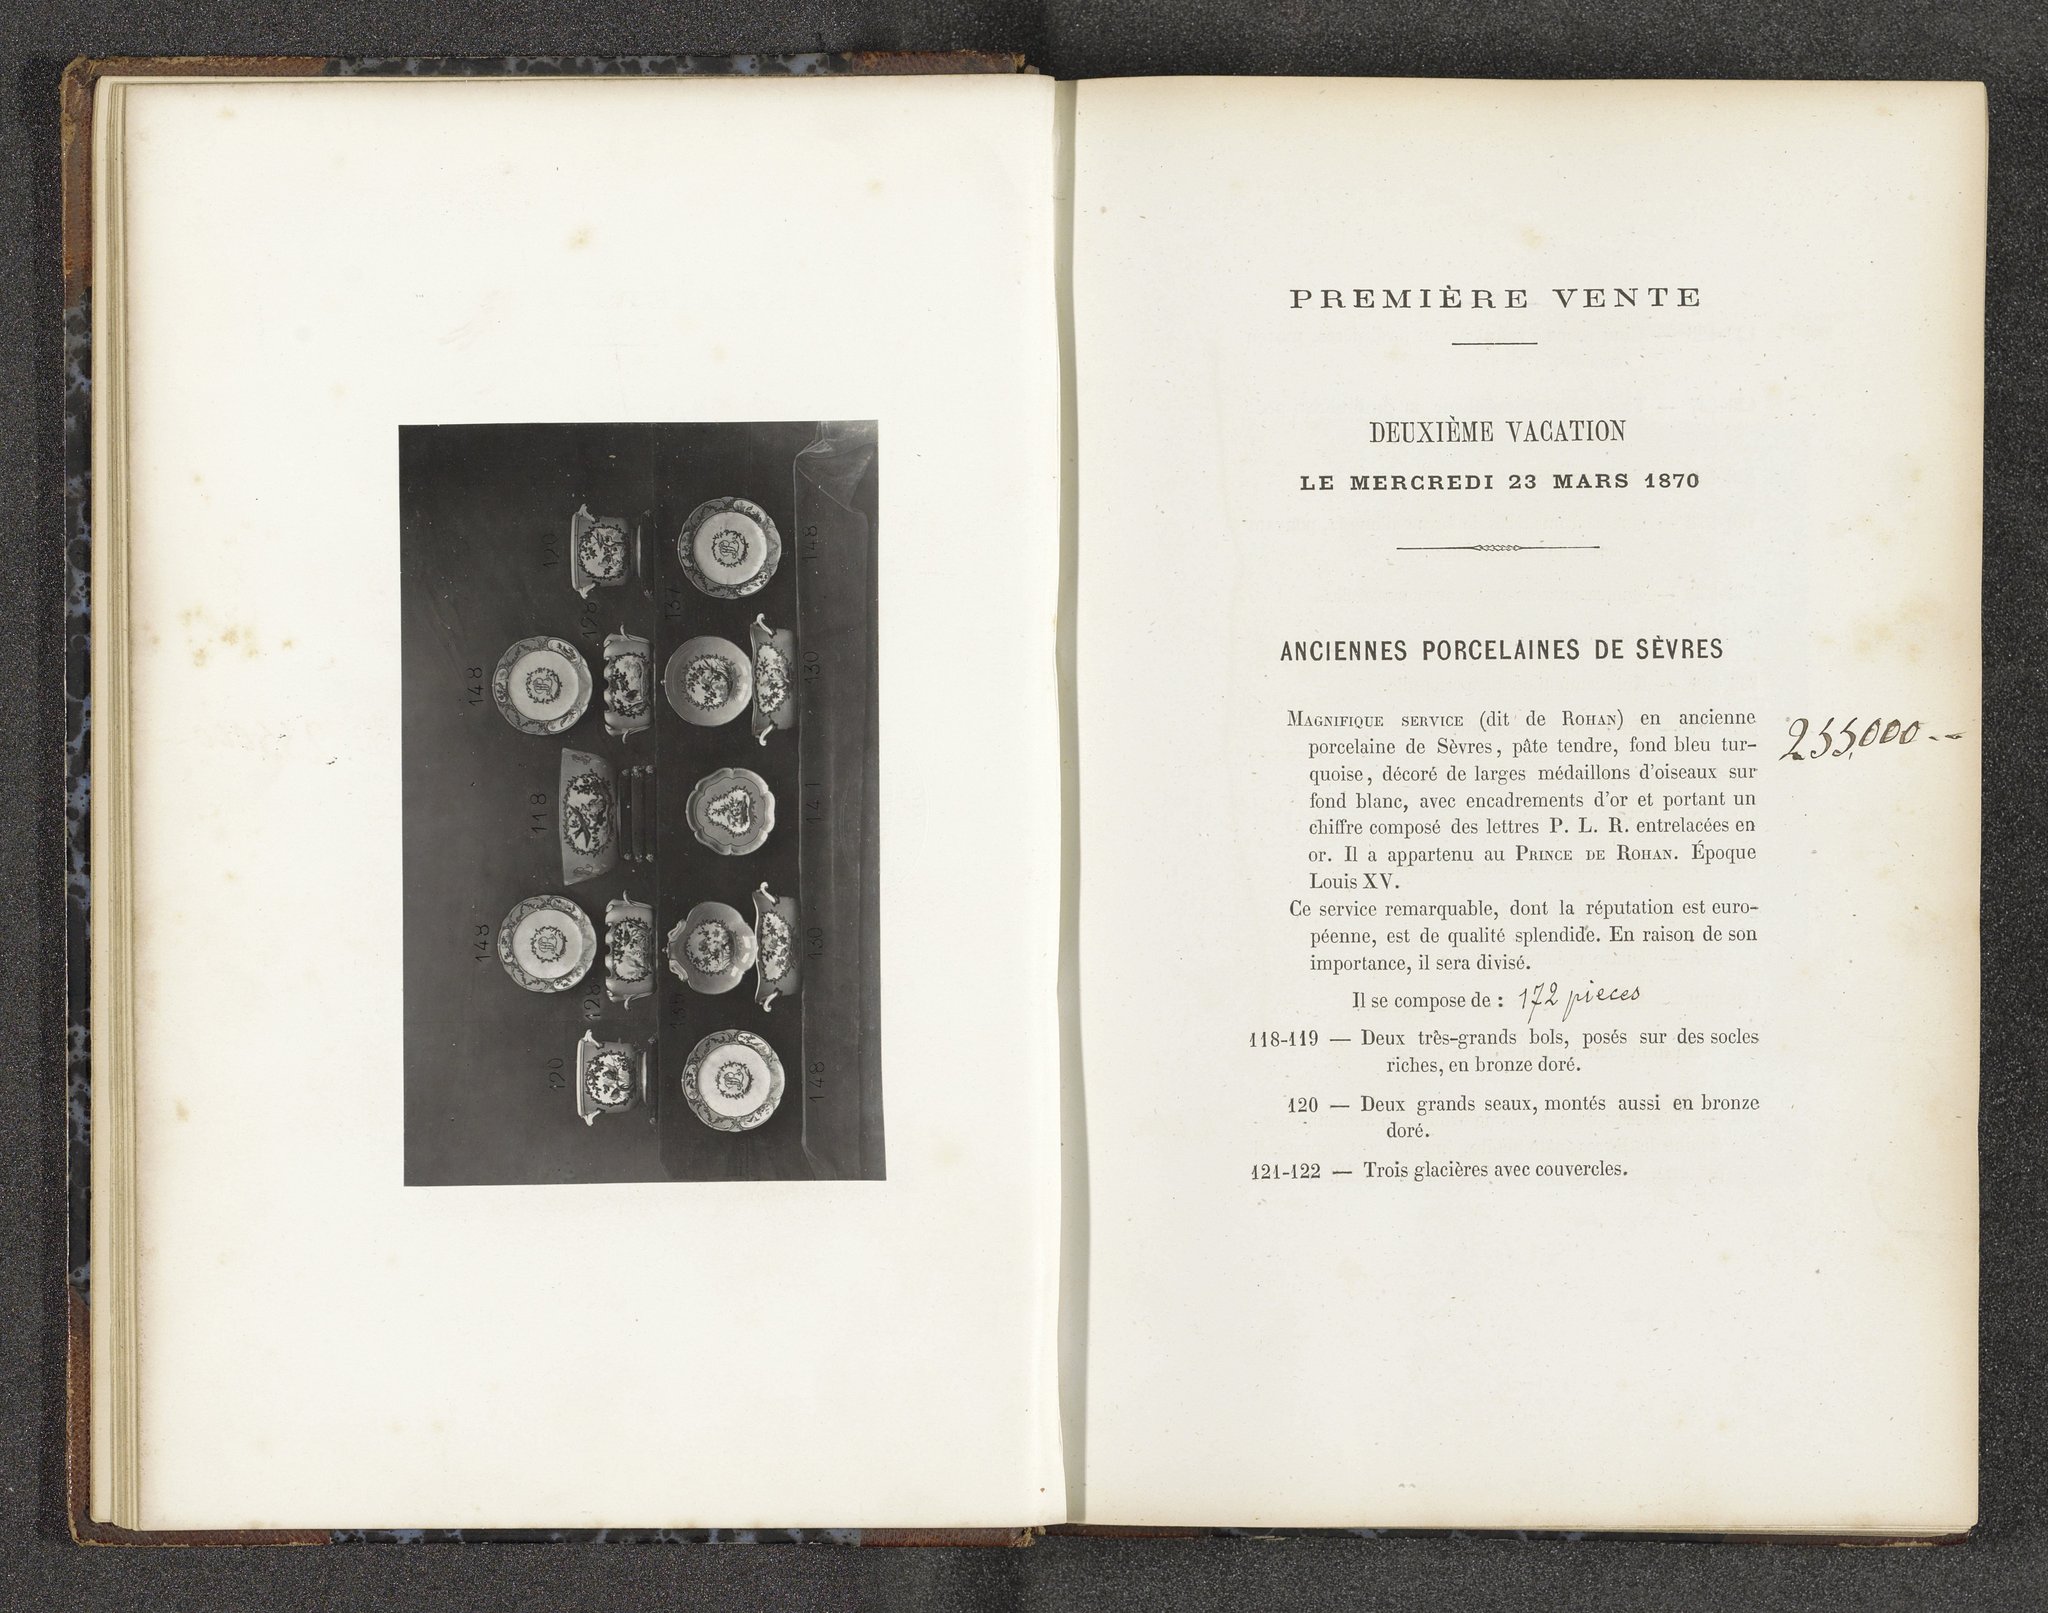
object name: photomechanical print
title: Veertien borden, schalen en kommen door Manufacture nationale de Sèvres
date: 1870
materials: paper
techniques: woodburytype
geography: paris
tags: dinner-service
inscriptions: name: ‘De Goupil & Cie Imp. Photoglytique Paris’, number: ‘118 120 128 130 137 141 148’